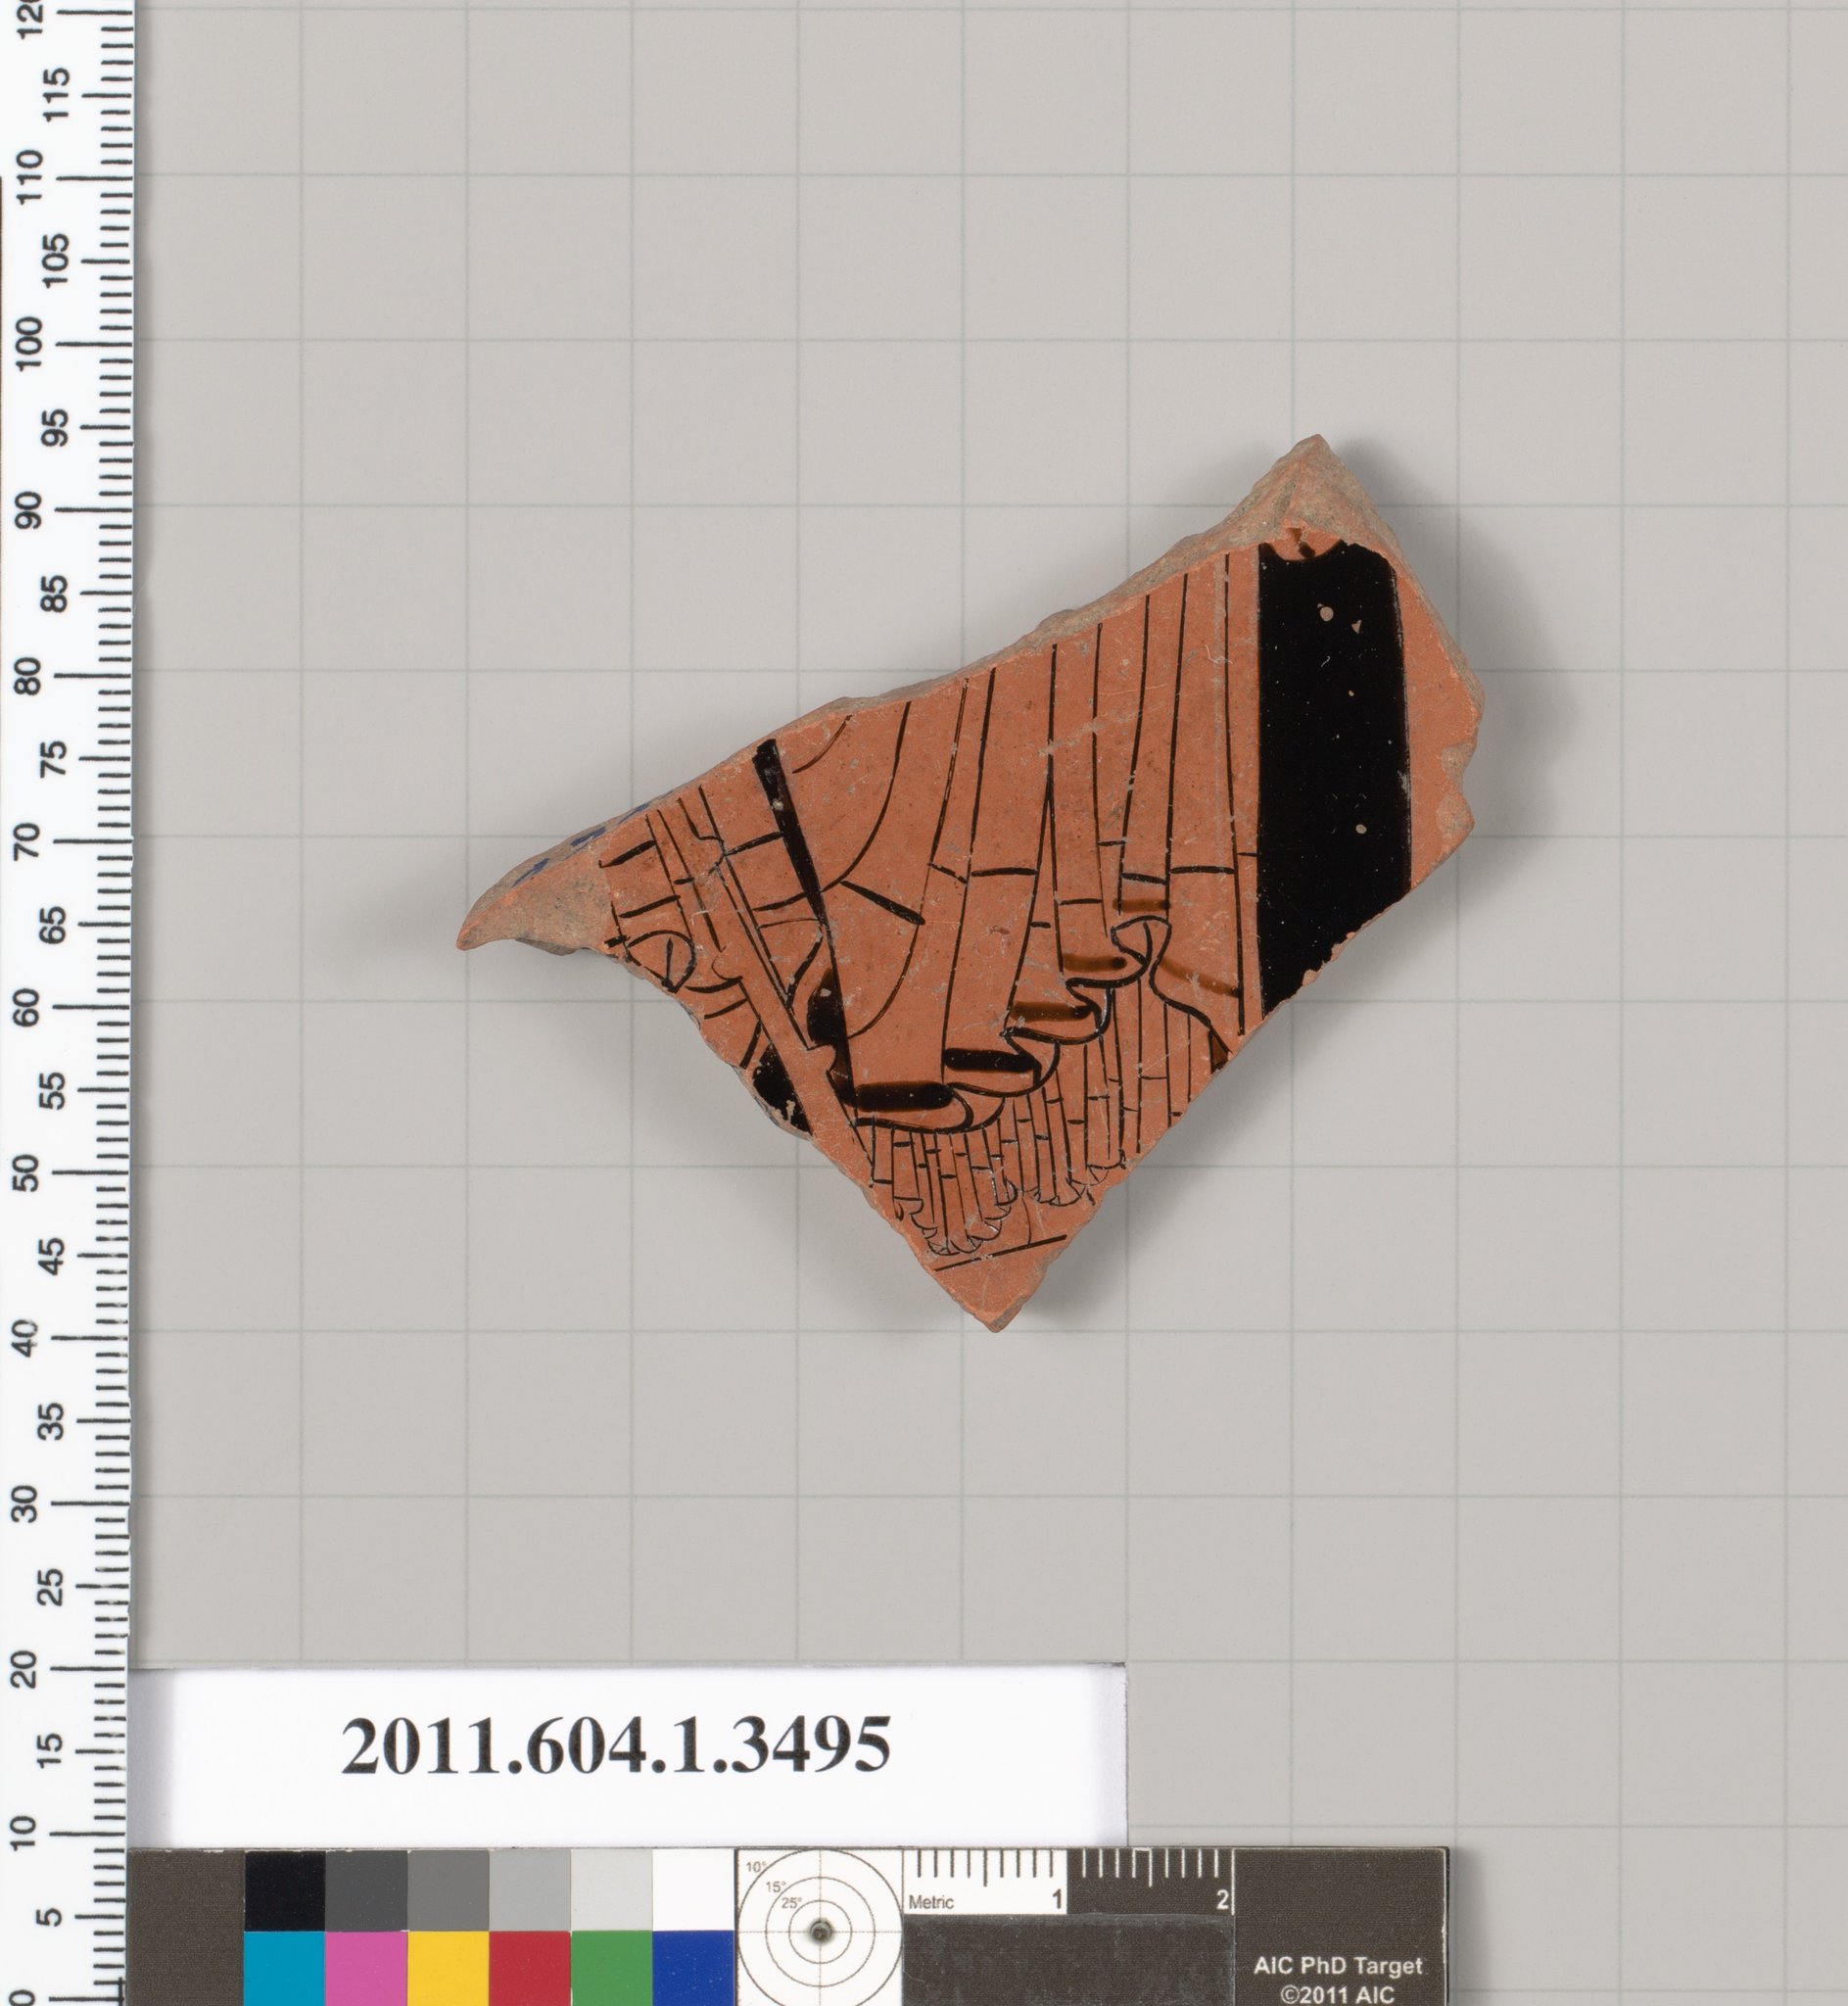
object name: kylix fragment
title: Terracotta fragment of a kylix (drinking cup)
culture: greek, attic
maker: makron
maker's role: artist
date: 490-480 BCE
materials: terracotta